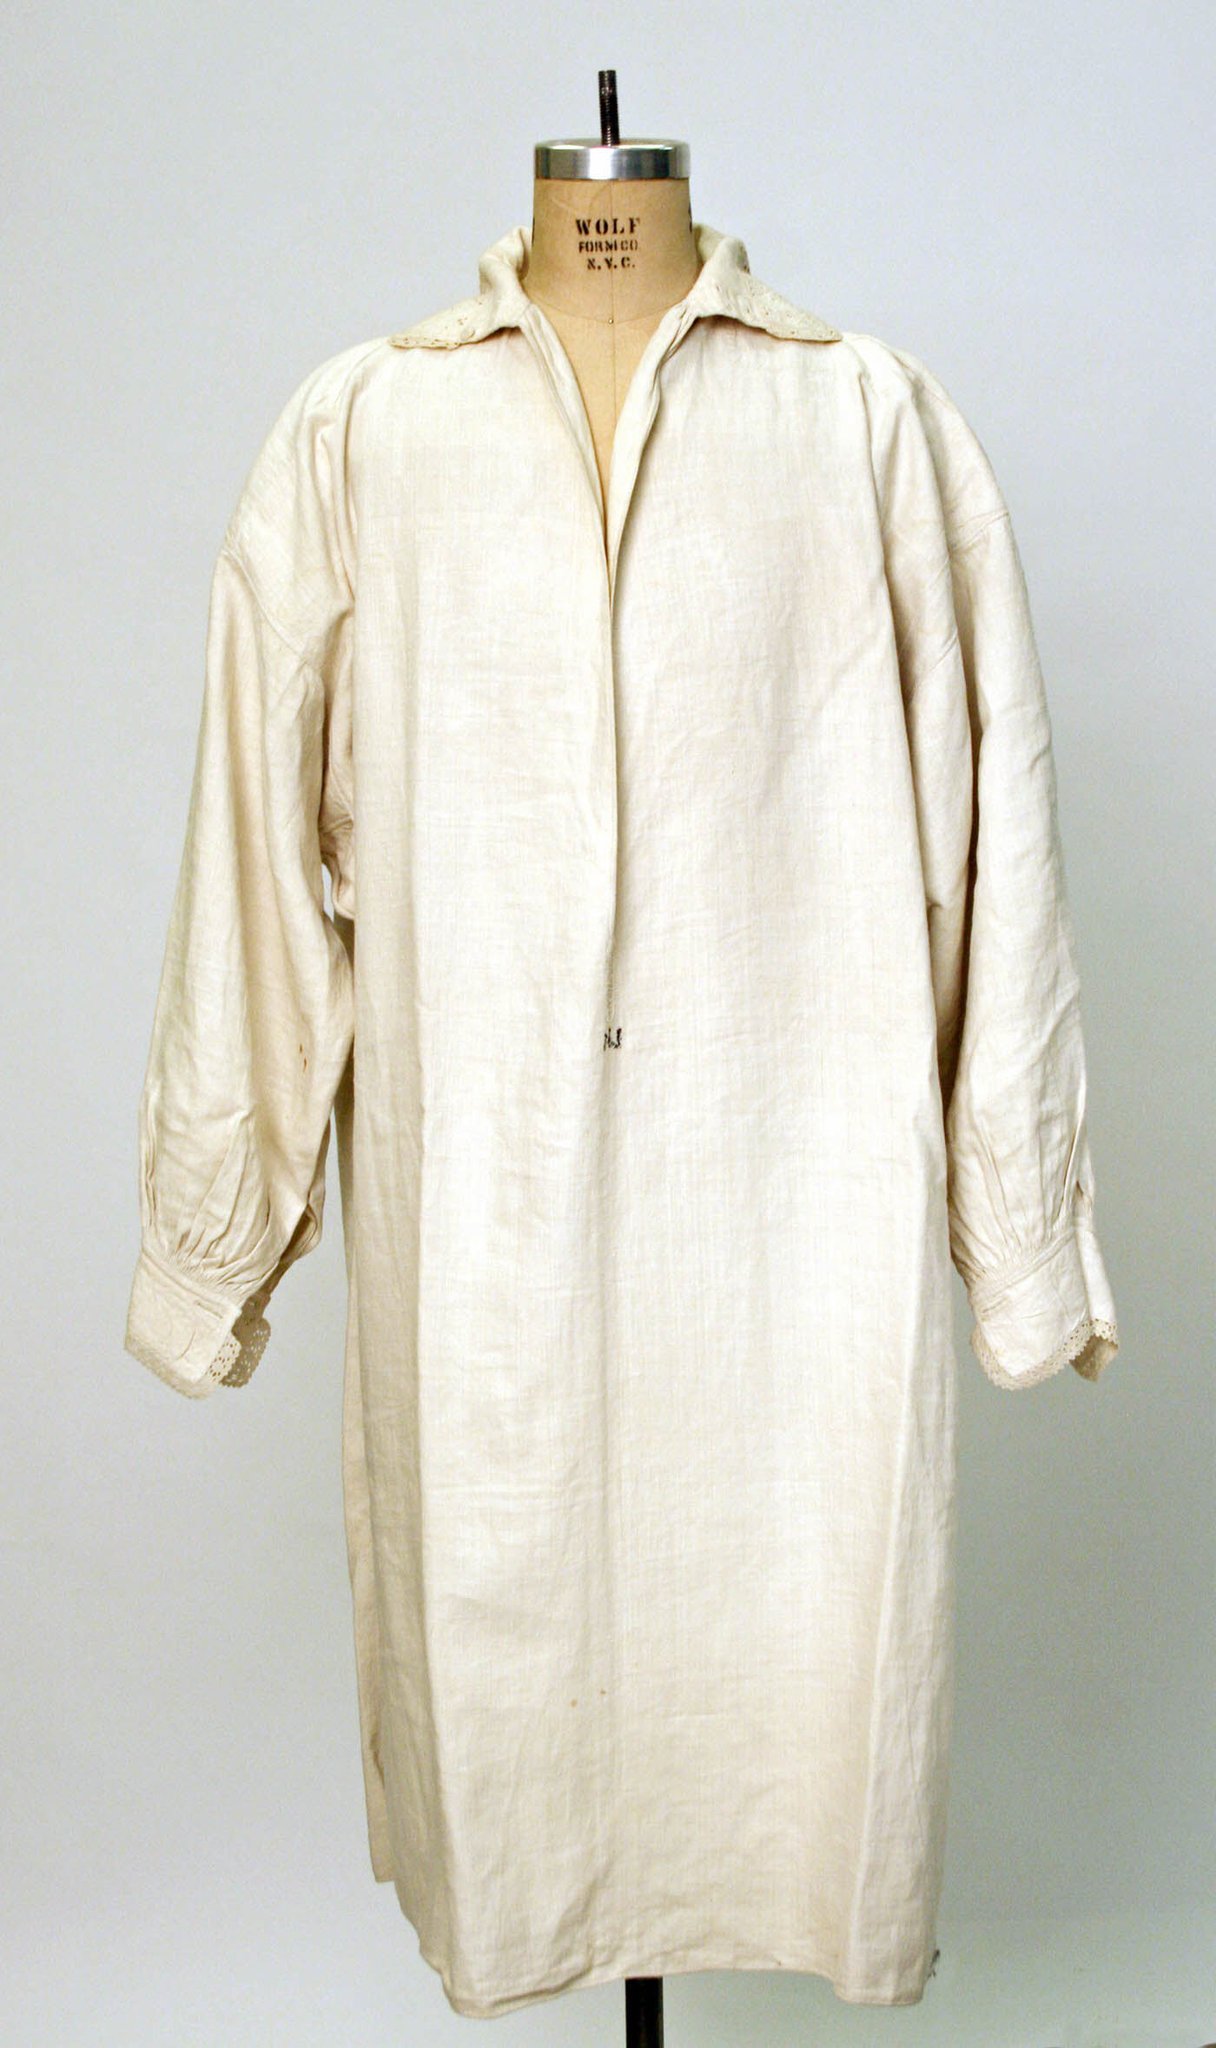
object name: shirt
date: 1801-1900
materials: linen